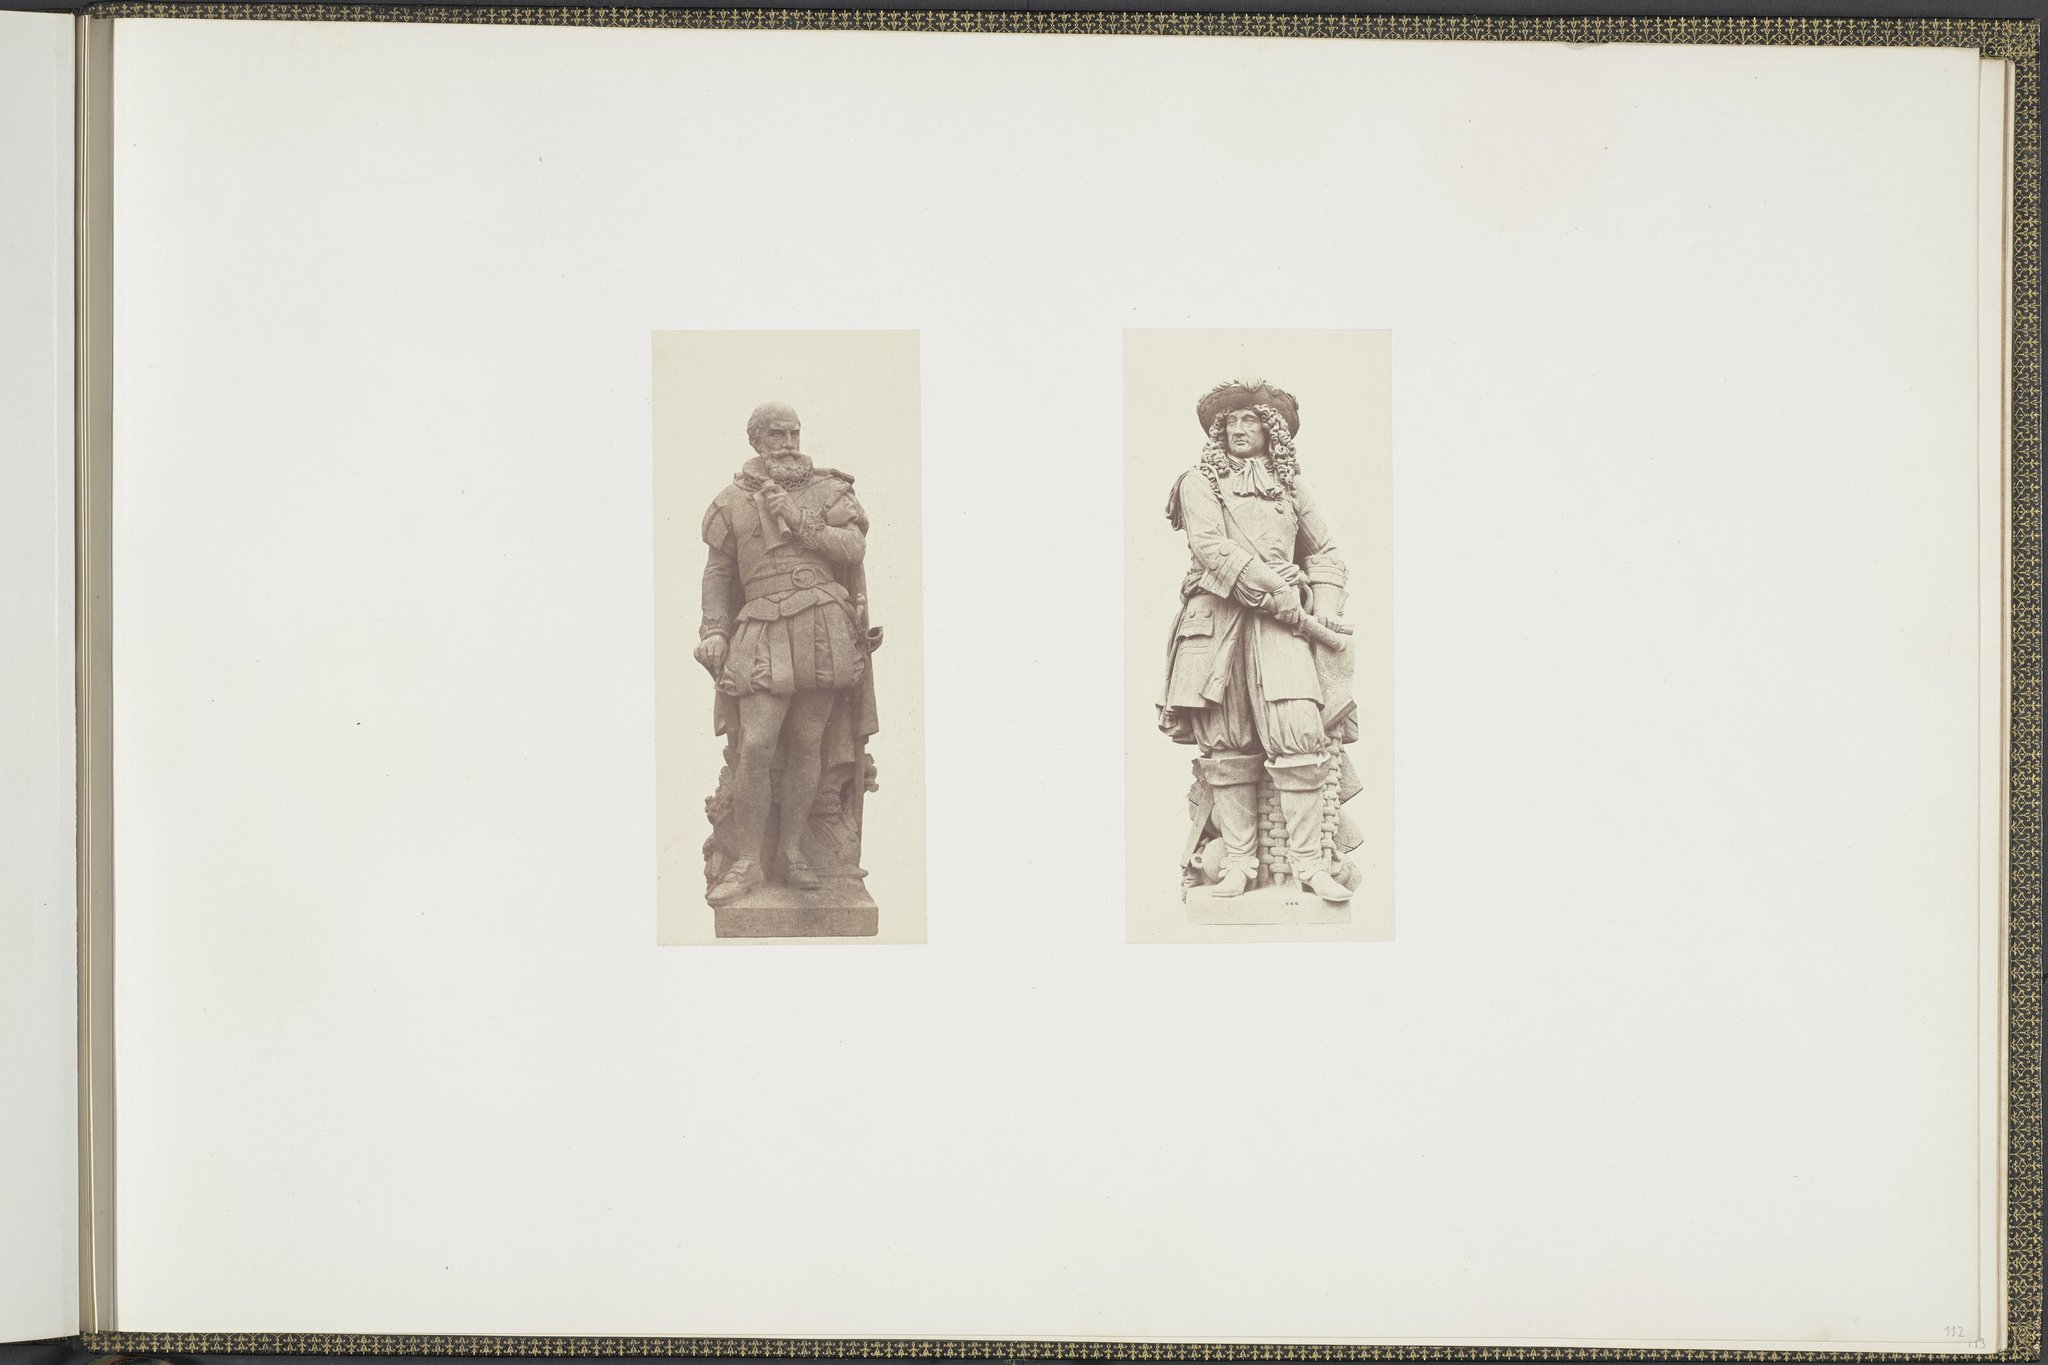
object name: photograph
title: Gipsmodellen voor beeldhouwwerken op het Palais du Louvre: links "Sully" door Vital Dubray en rechts "Vauban" door Gustave Crauk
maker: édouard denis baldus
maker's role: fotograaf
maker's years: 1813-1889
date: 1855-1857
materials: paper, photographic support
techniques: salted paper print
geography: paris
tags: piece of sculpture, reproduction of a piece of sculpture, permanent exhibition, museum, paris, tuileries palace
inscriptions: number: ‘906’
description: Onderdeel van Réunion des Tuileries au Louvre 1852-1857, album 1.